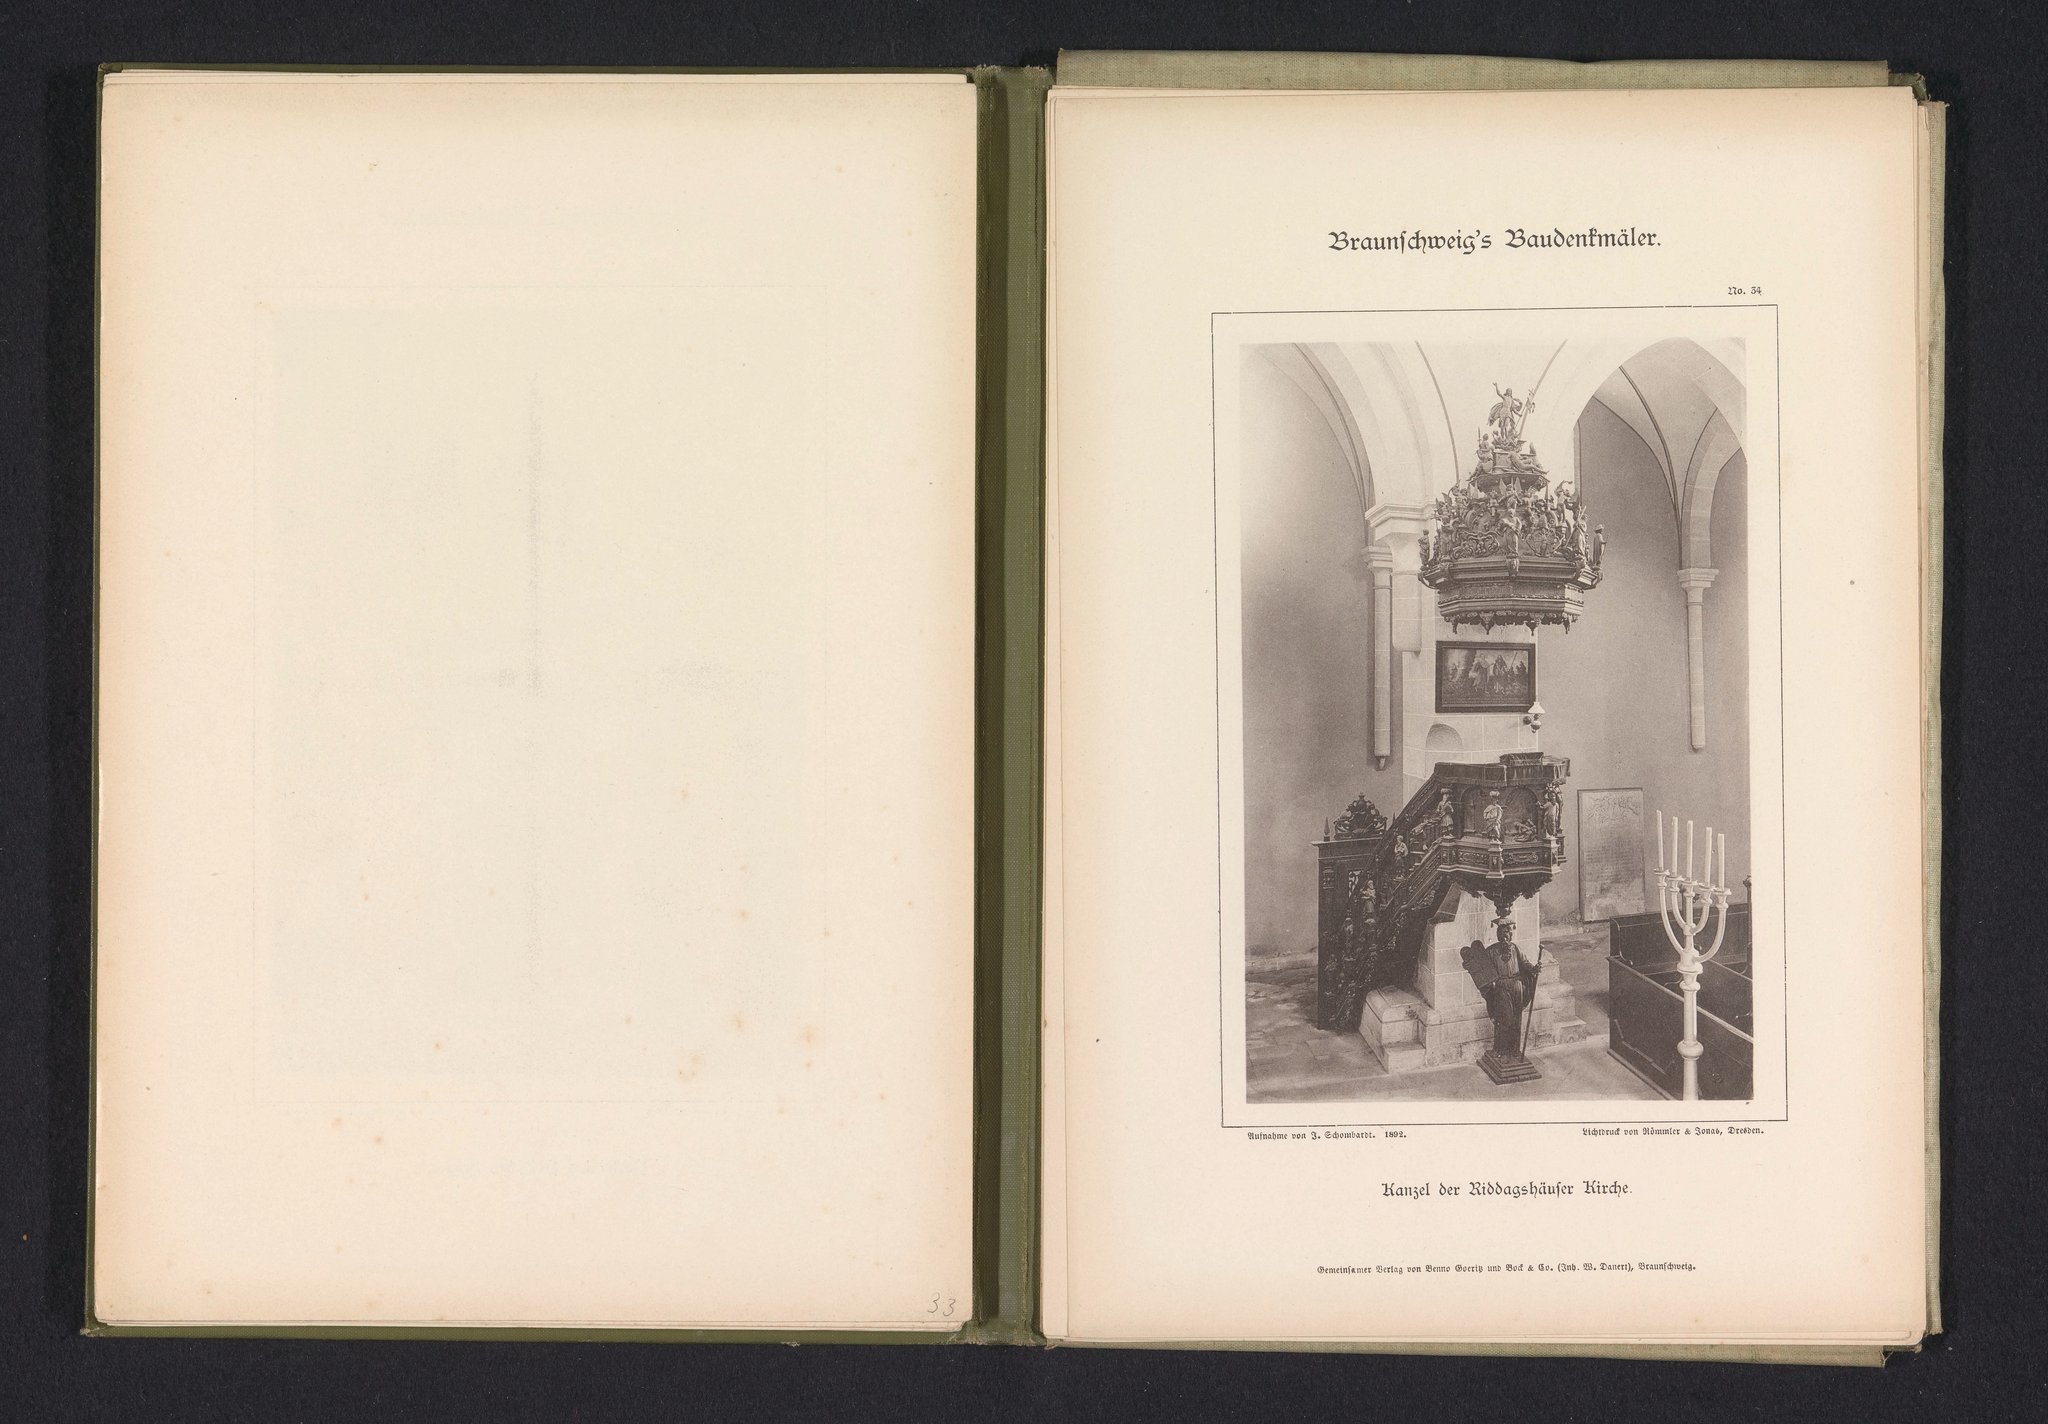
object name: page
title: Braunschweig's Baudenkmäler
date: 1892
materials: paper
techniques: photograph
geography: riddagshausen abbey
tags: abbey, monastery, convent ~ roman catholic church, pulpit, ambo, chancel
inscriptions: number: ‘No. 34.’